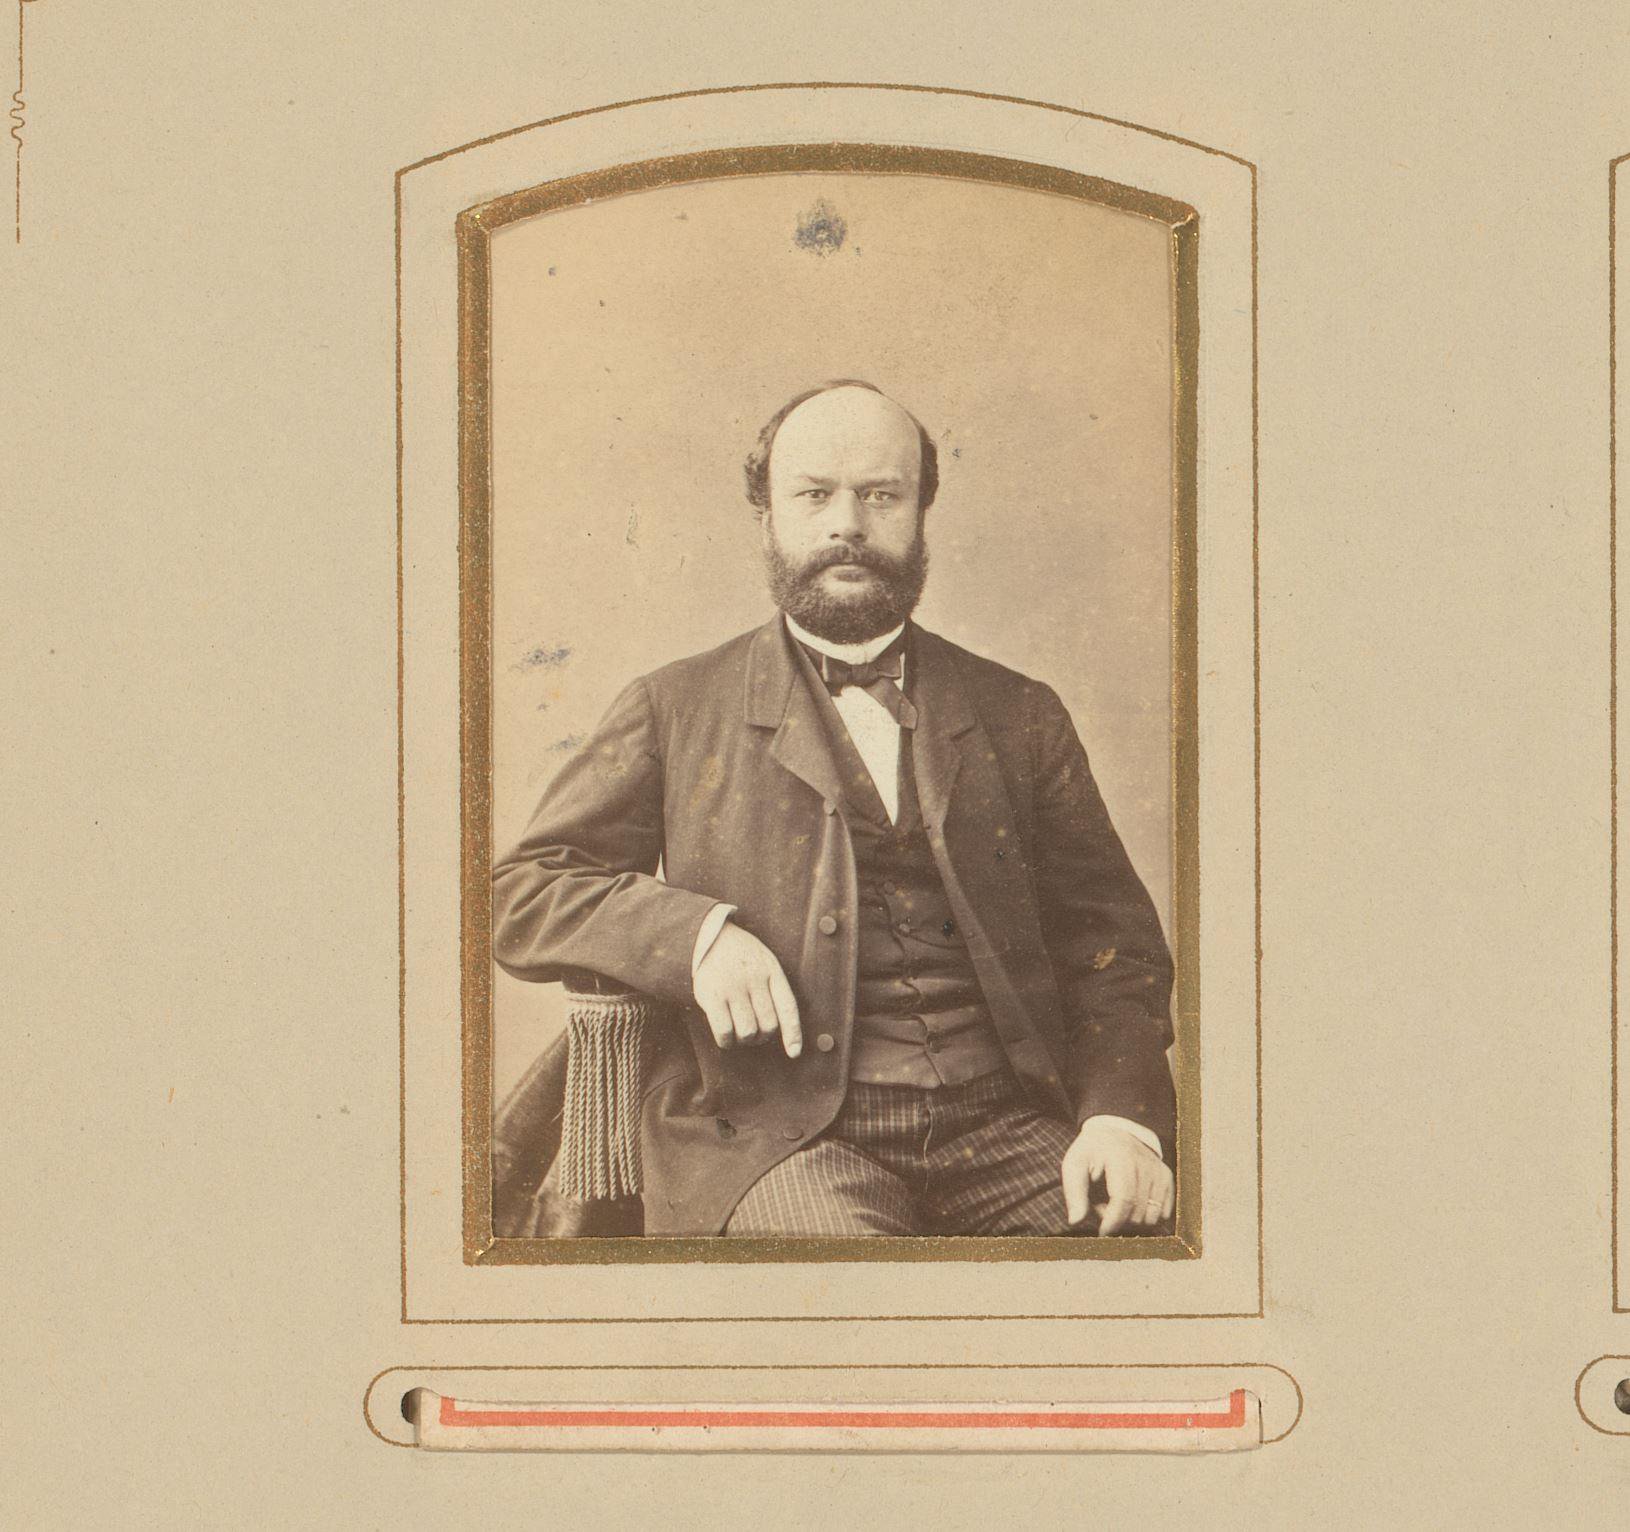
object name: photograph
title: Portret van een zittende man met snor en baard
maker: félix nadar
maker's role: ballonvaarder, fotograaf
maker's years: 1820-1910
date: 1873-1900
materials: cardboard, photographic support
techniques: albumen print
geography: paris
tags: sitting figure, historical persons, beard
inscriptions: inscription: ‘PHOTOGRAPHIE DU GRAND HÔTEL/ Nadar/ 35, Boulevart des Capucines.’